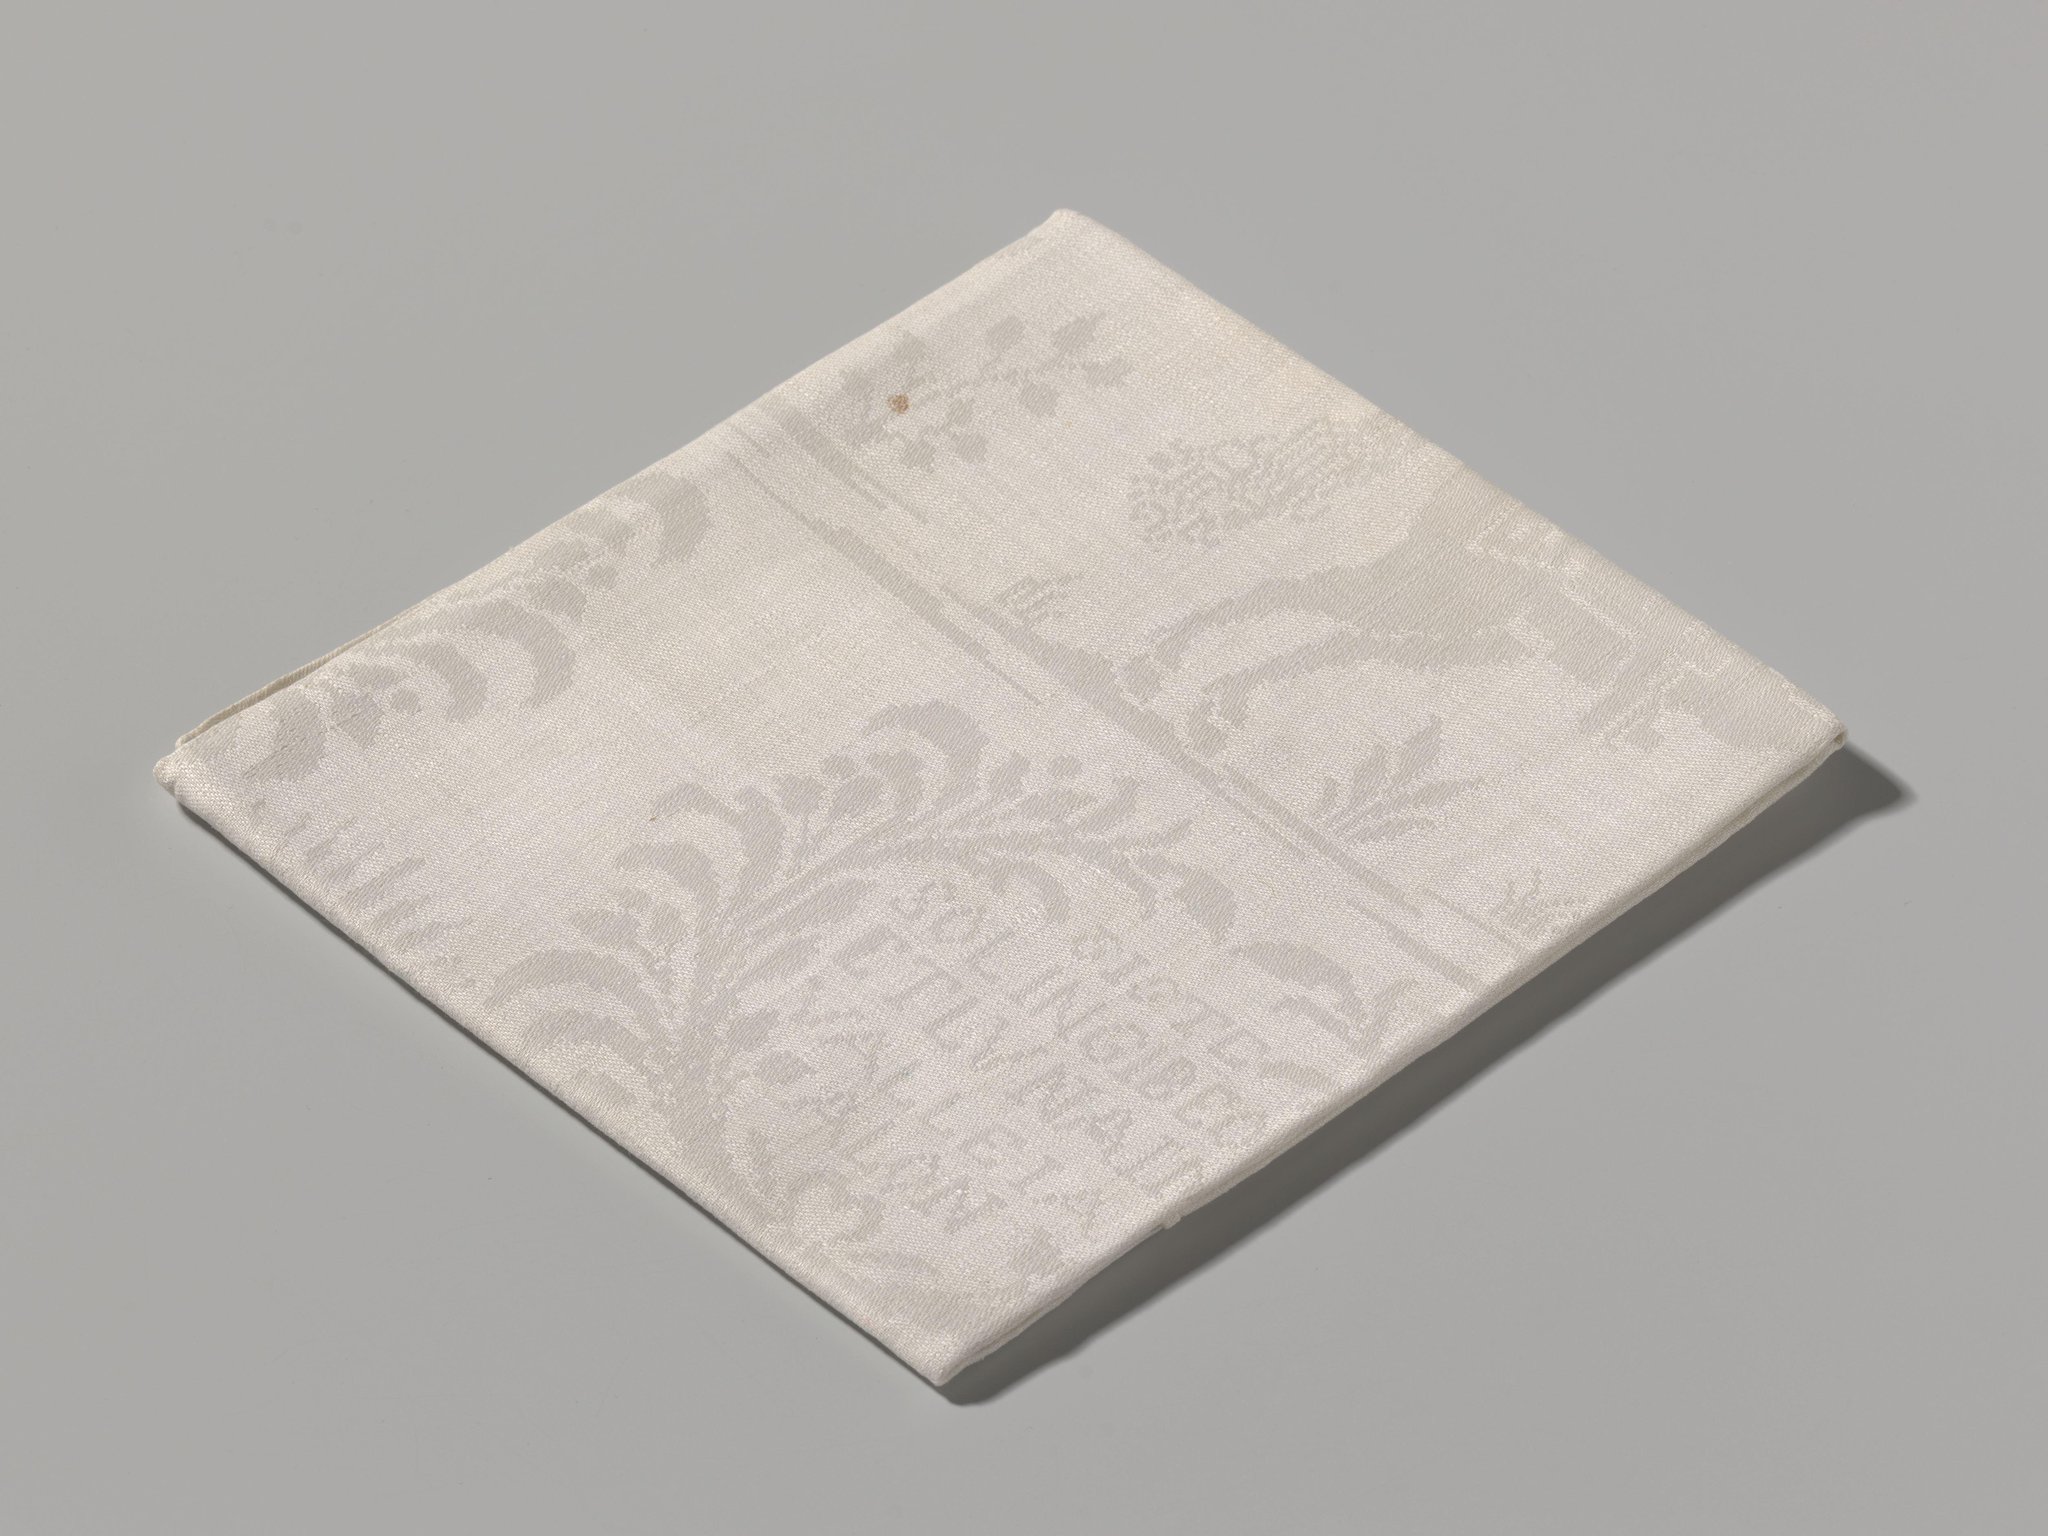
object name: tablecloth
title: Fragment van een tafellaken met de inname van Rijssel door Eugenius van Savoye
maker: Anonymous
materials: linen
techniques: damask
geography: kortrijk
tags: vienna, eugenius van savoye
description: Fragment van een tafellaken van linnendamast met de inname van Rijssel door Eugenius van Savoye. Twee ruiters met het bijschrift: EGENIUS. In drie kransen de tekst: SISTE SOL IN GIBEON, ET LUNA IN VALLE...IA-ALON (Blijf staan, zon, te Gibeon en gij, maan, in het dal van Ajalon, Josua 9:13), de zon en de maan en het bijschrift: RIS-SEL. Staande randen: Doorlopende ranken.